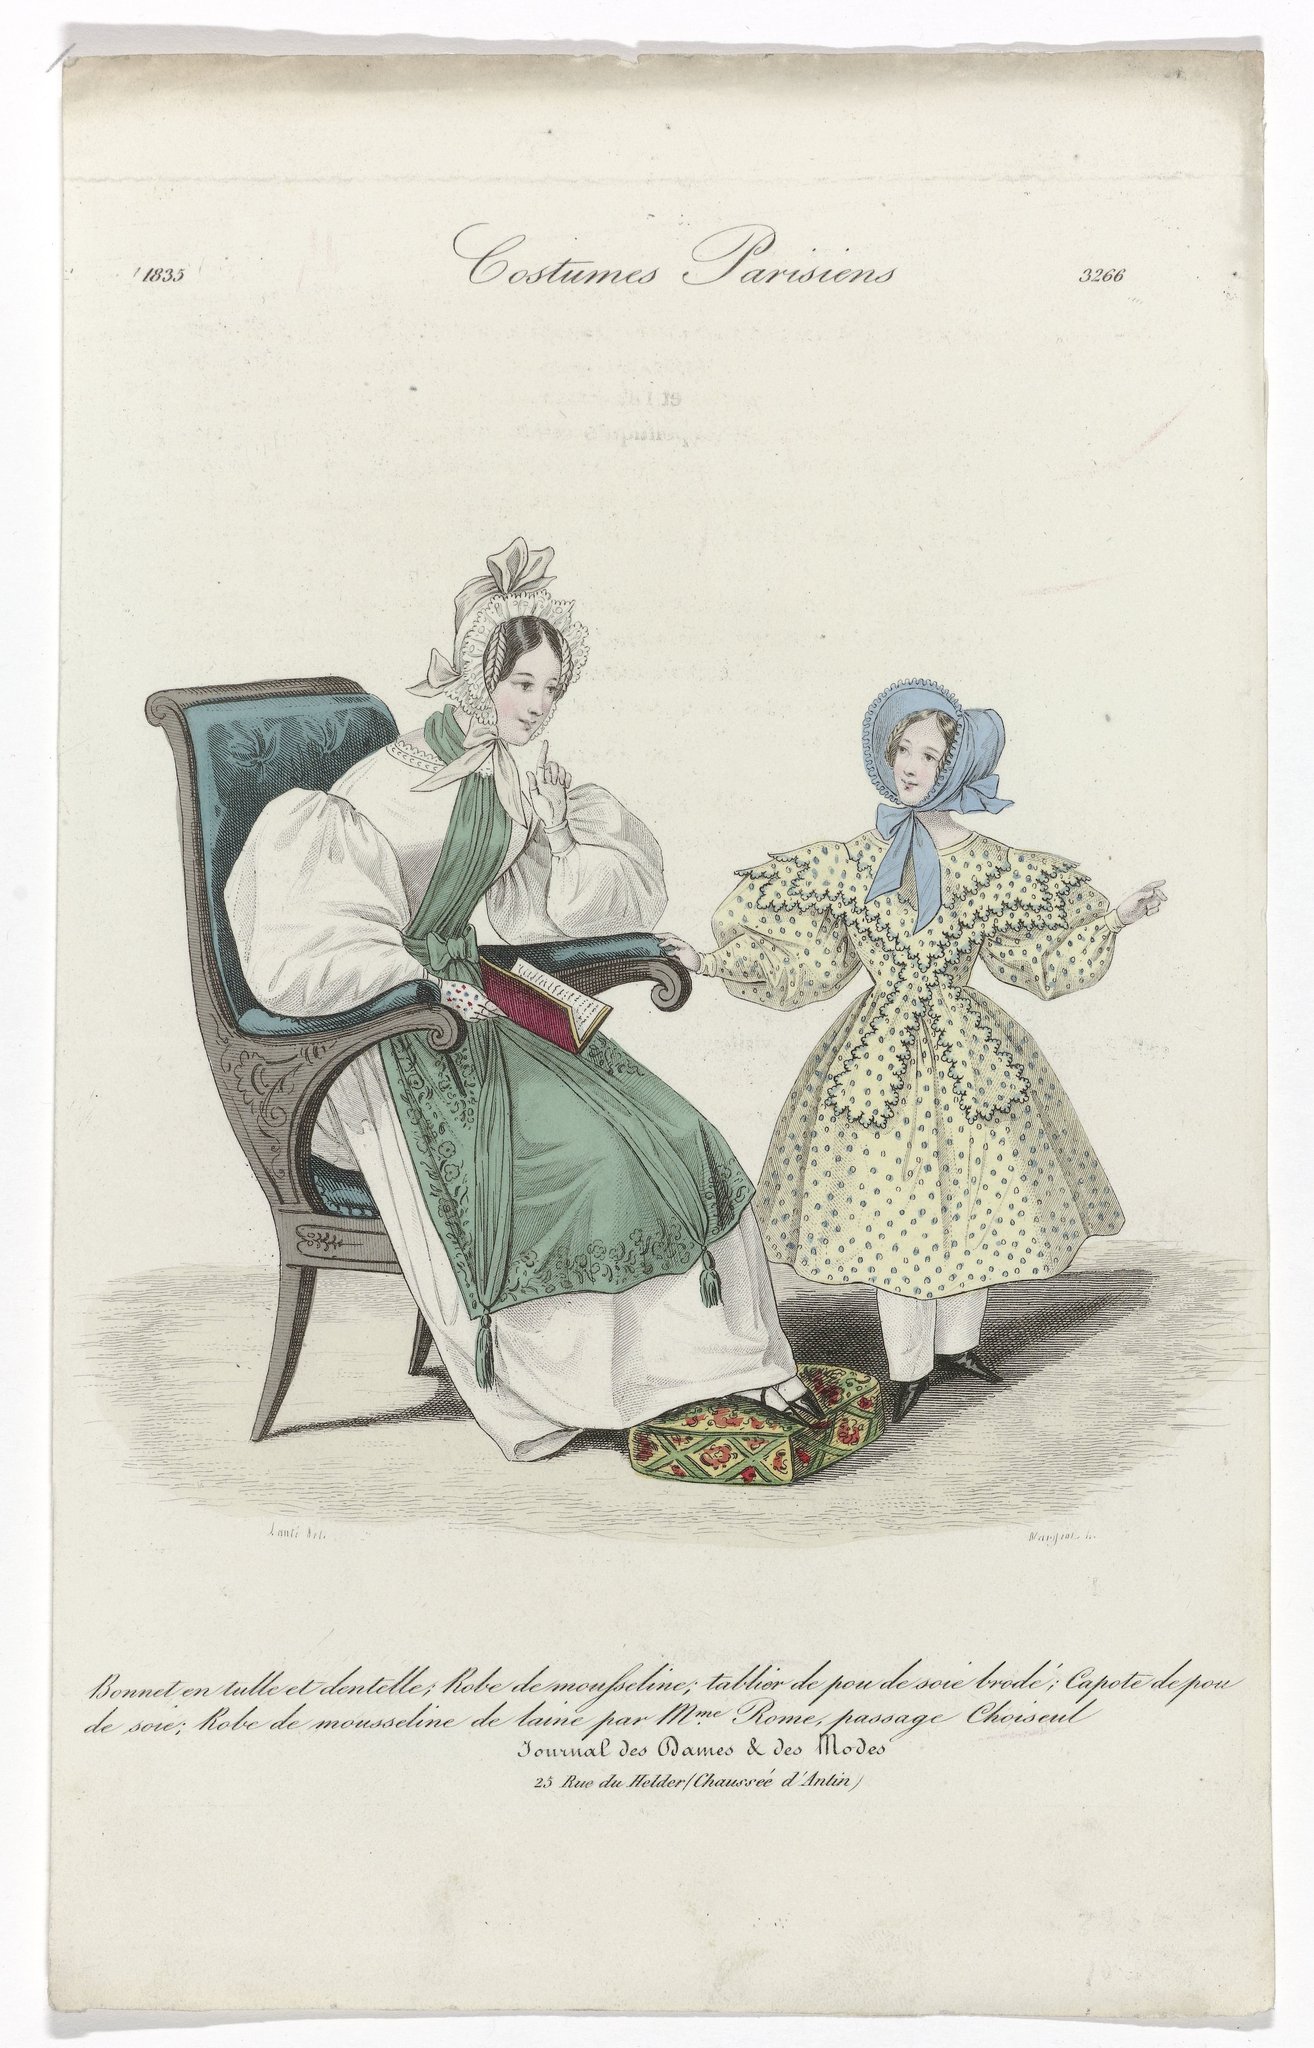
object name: fashion print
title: Journal des Dames et des Modes, Costumes Parisiens, 1835, (3266): Bonnet en tull (...)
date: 1835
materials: paper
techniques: engraving, hand coloring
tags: gloves, mittens (mitaines) (+ women's clothes), shoes, sandals (+ girls' clothes), underclothes for the lower part of the body: bloomers (+ girls' clothes), head-gear (capote) (+ girls' clothes), head-gear: cap (+ women's clothes), fashion plates, shoes, sandals (+ women's clothes), dress, gown (+ women's clothes), book - mm - book open, apron (+ women's clothes), dress, gown (+ girls' clothes)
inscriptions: address: ‘Journal des Dames & des Modes / 25 Rue du Helder ( Chaussée d'Antin )’, title: ‘Costumes Parisiens.’, caption: ‘Bonnet en tulle et dentelle; Robe de mousseline; tablier de pou de soie brodé; Capote de pou de soie; Robe de mousseline de laine par M.me Rome, passage Choiseul.’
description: Vrouw, zittend op een armstoel, met op het hoofd een muts van tule en kant. Zij draagt een japon van mousseline met een schort van geborduurde tafzijde. Verdere accessoires: mitaines, platte schoenen met vierkante neuzen. Geopend boek in de hand. Meisje met op het hoofd een 'capote' van tafzijde. Zij draagt een japon van wollen mousseline, door Rome. Lange broek. Schoenen met vierkante neuzen. De prent maakt deel uit van het modetijdschrift Journal des Dames et des Modes, Parijs, 1797-1839.